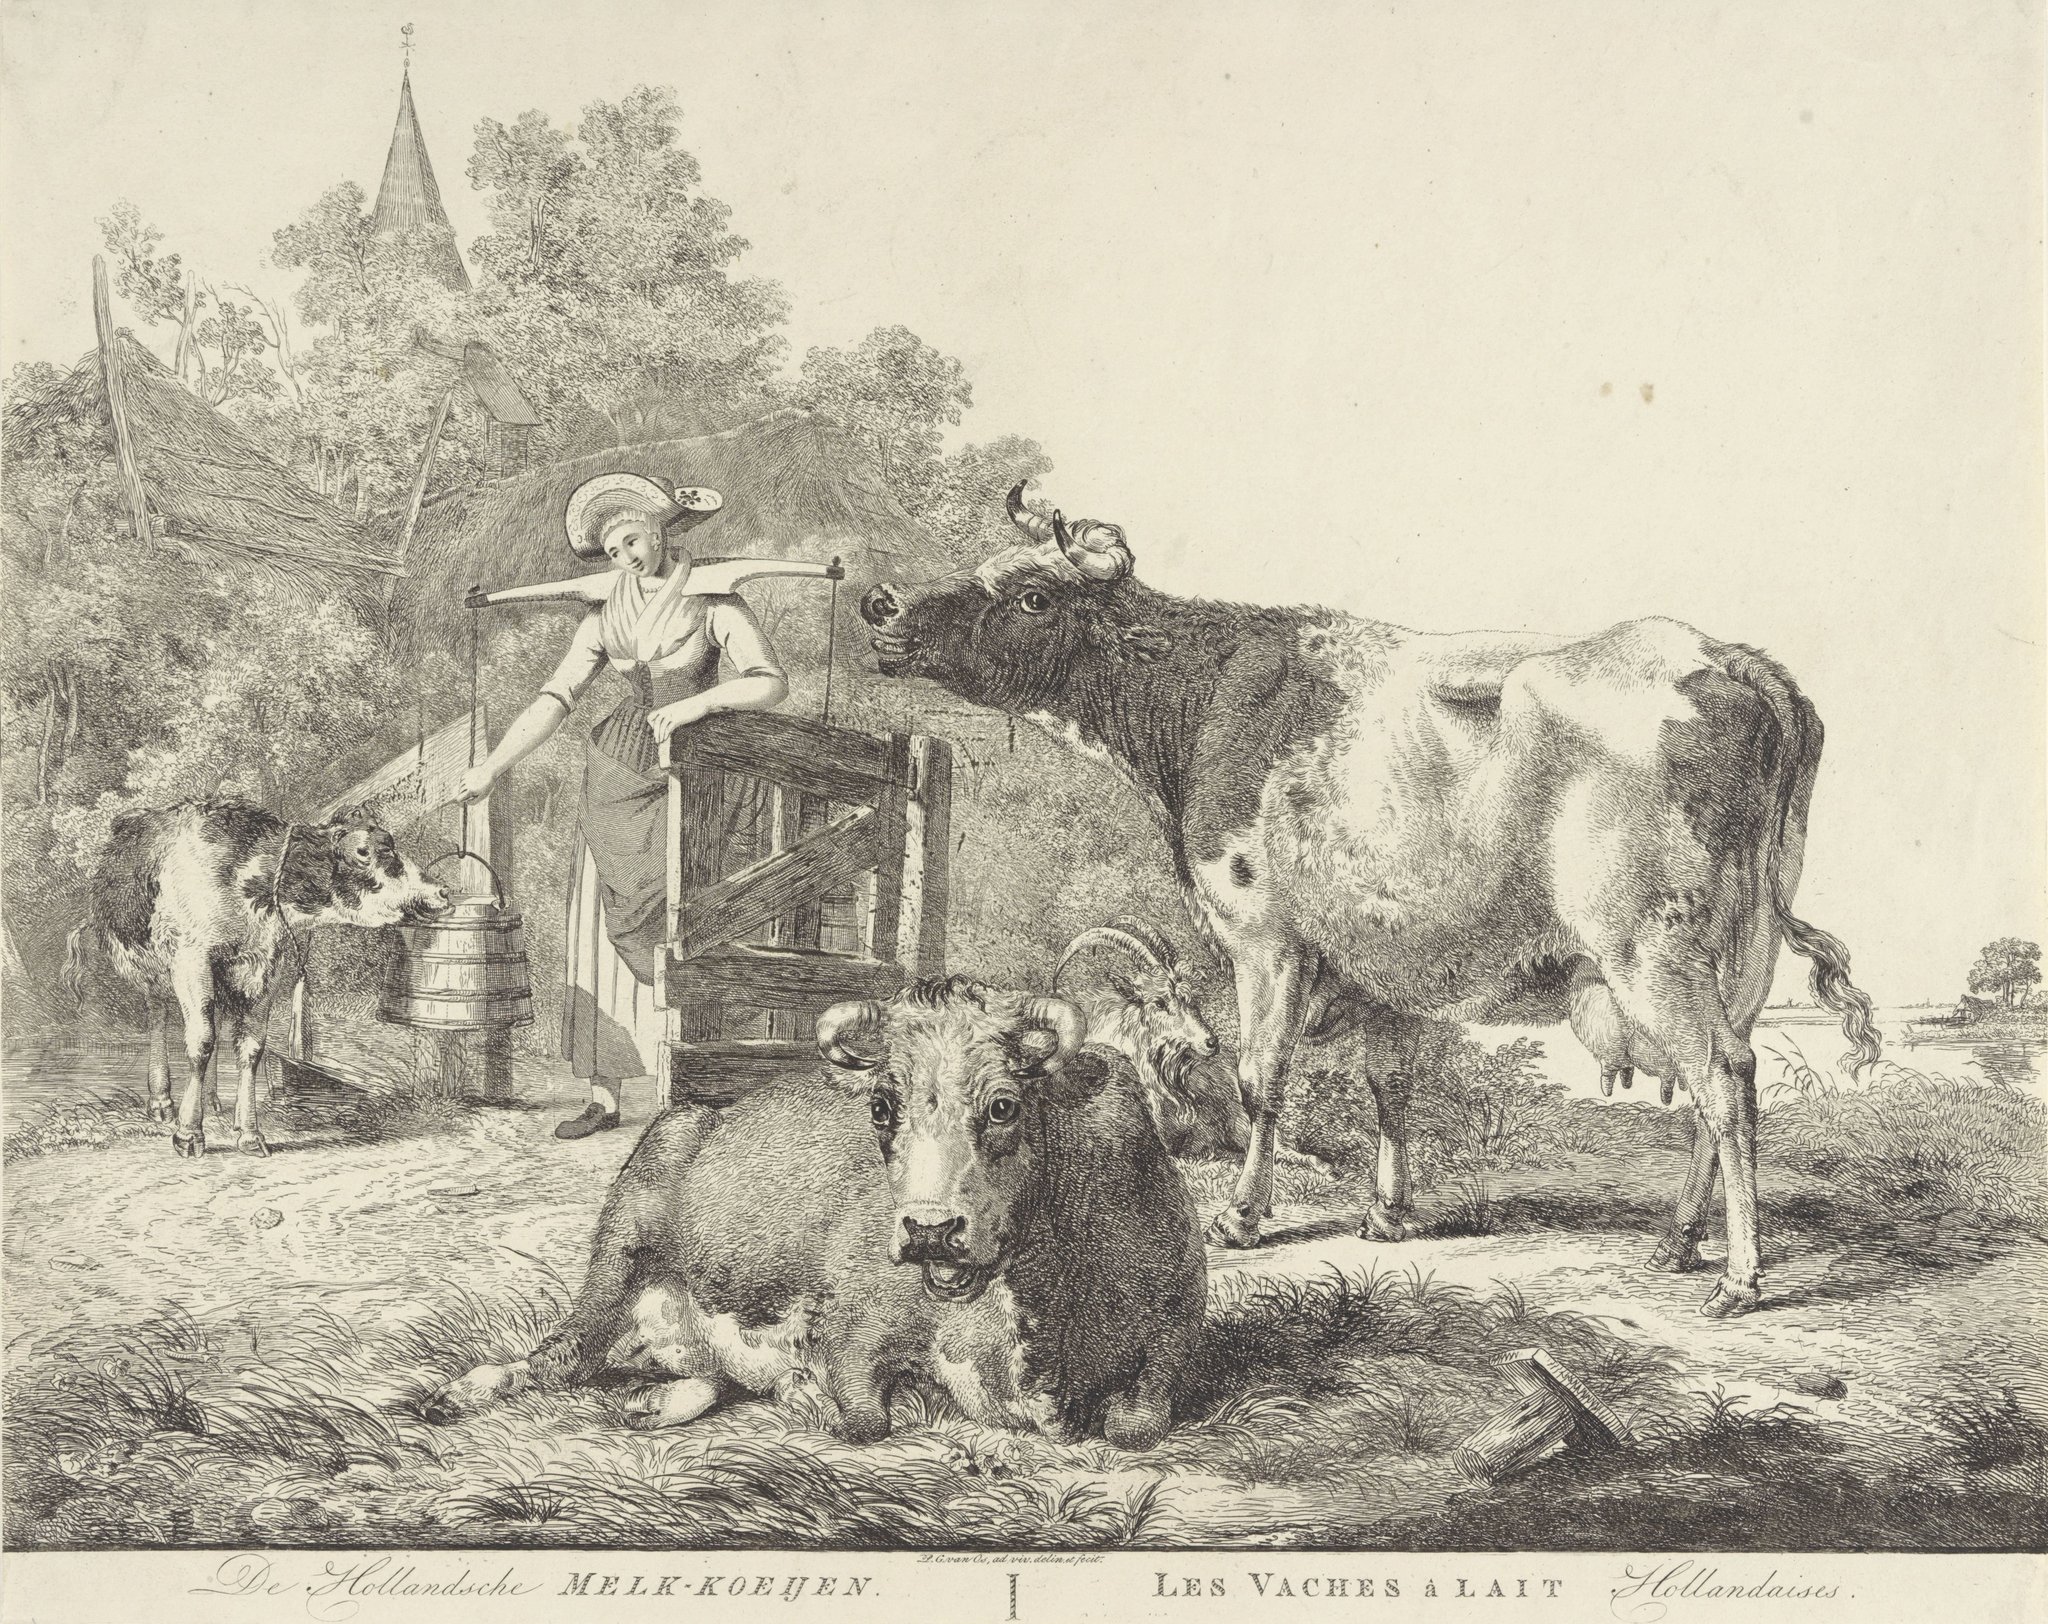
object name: print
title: De Hollandsche Melk-koeijen/ Les vaches â lait hollandaises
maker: pieter gerardus van os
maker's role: draughtsman, painter, print maker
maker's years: 1776-1839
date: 1803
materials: paper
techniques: drypoint, etching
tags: cow, milkmaid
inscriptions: collector's mark: Lugt 2228